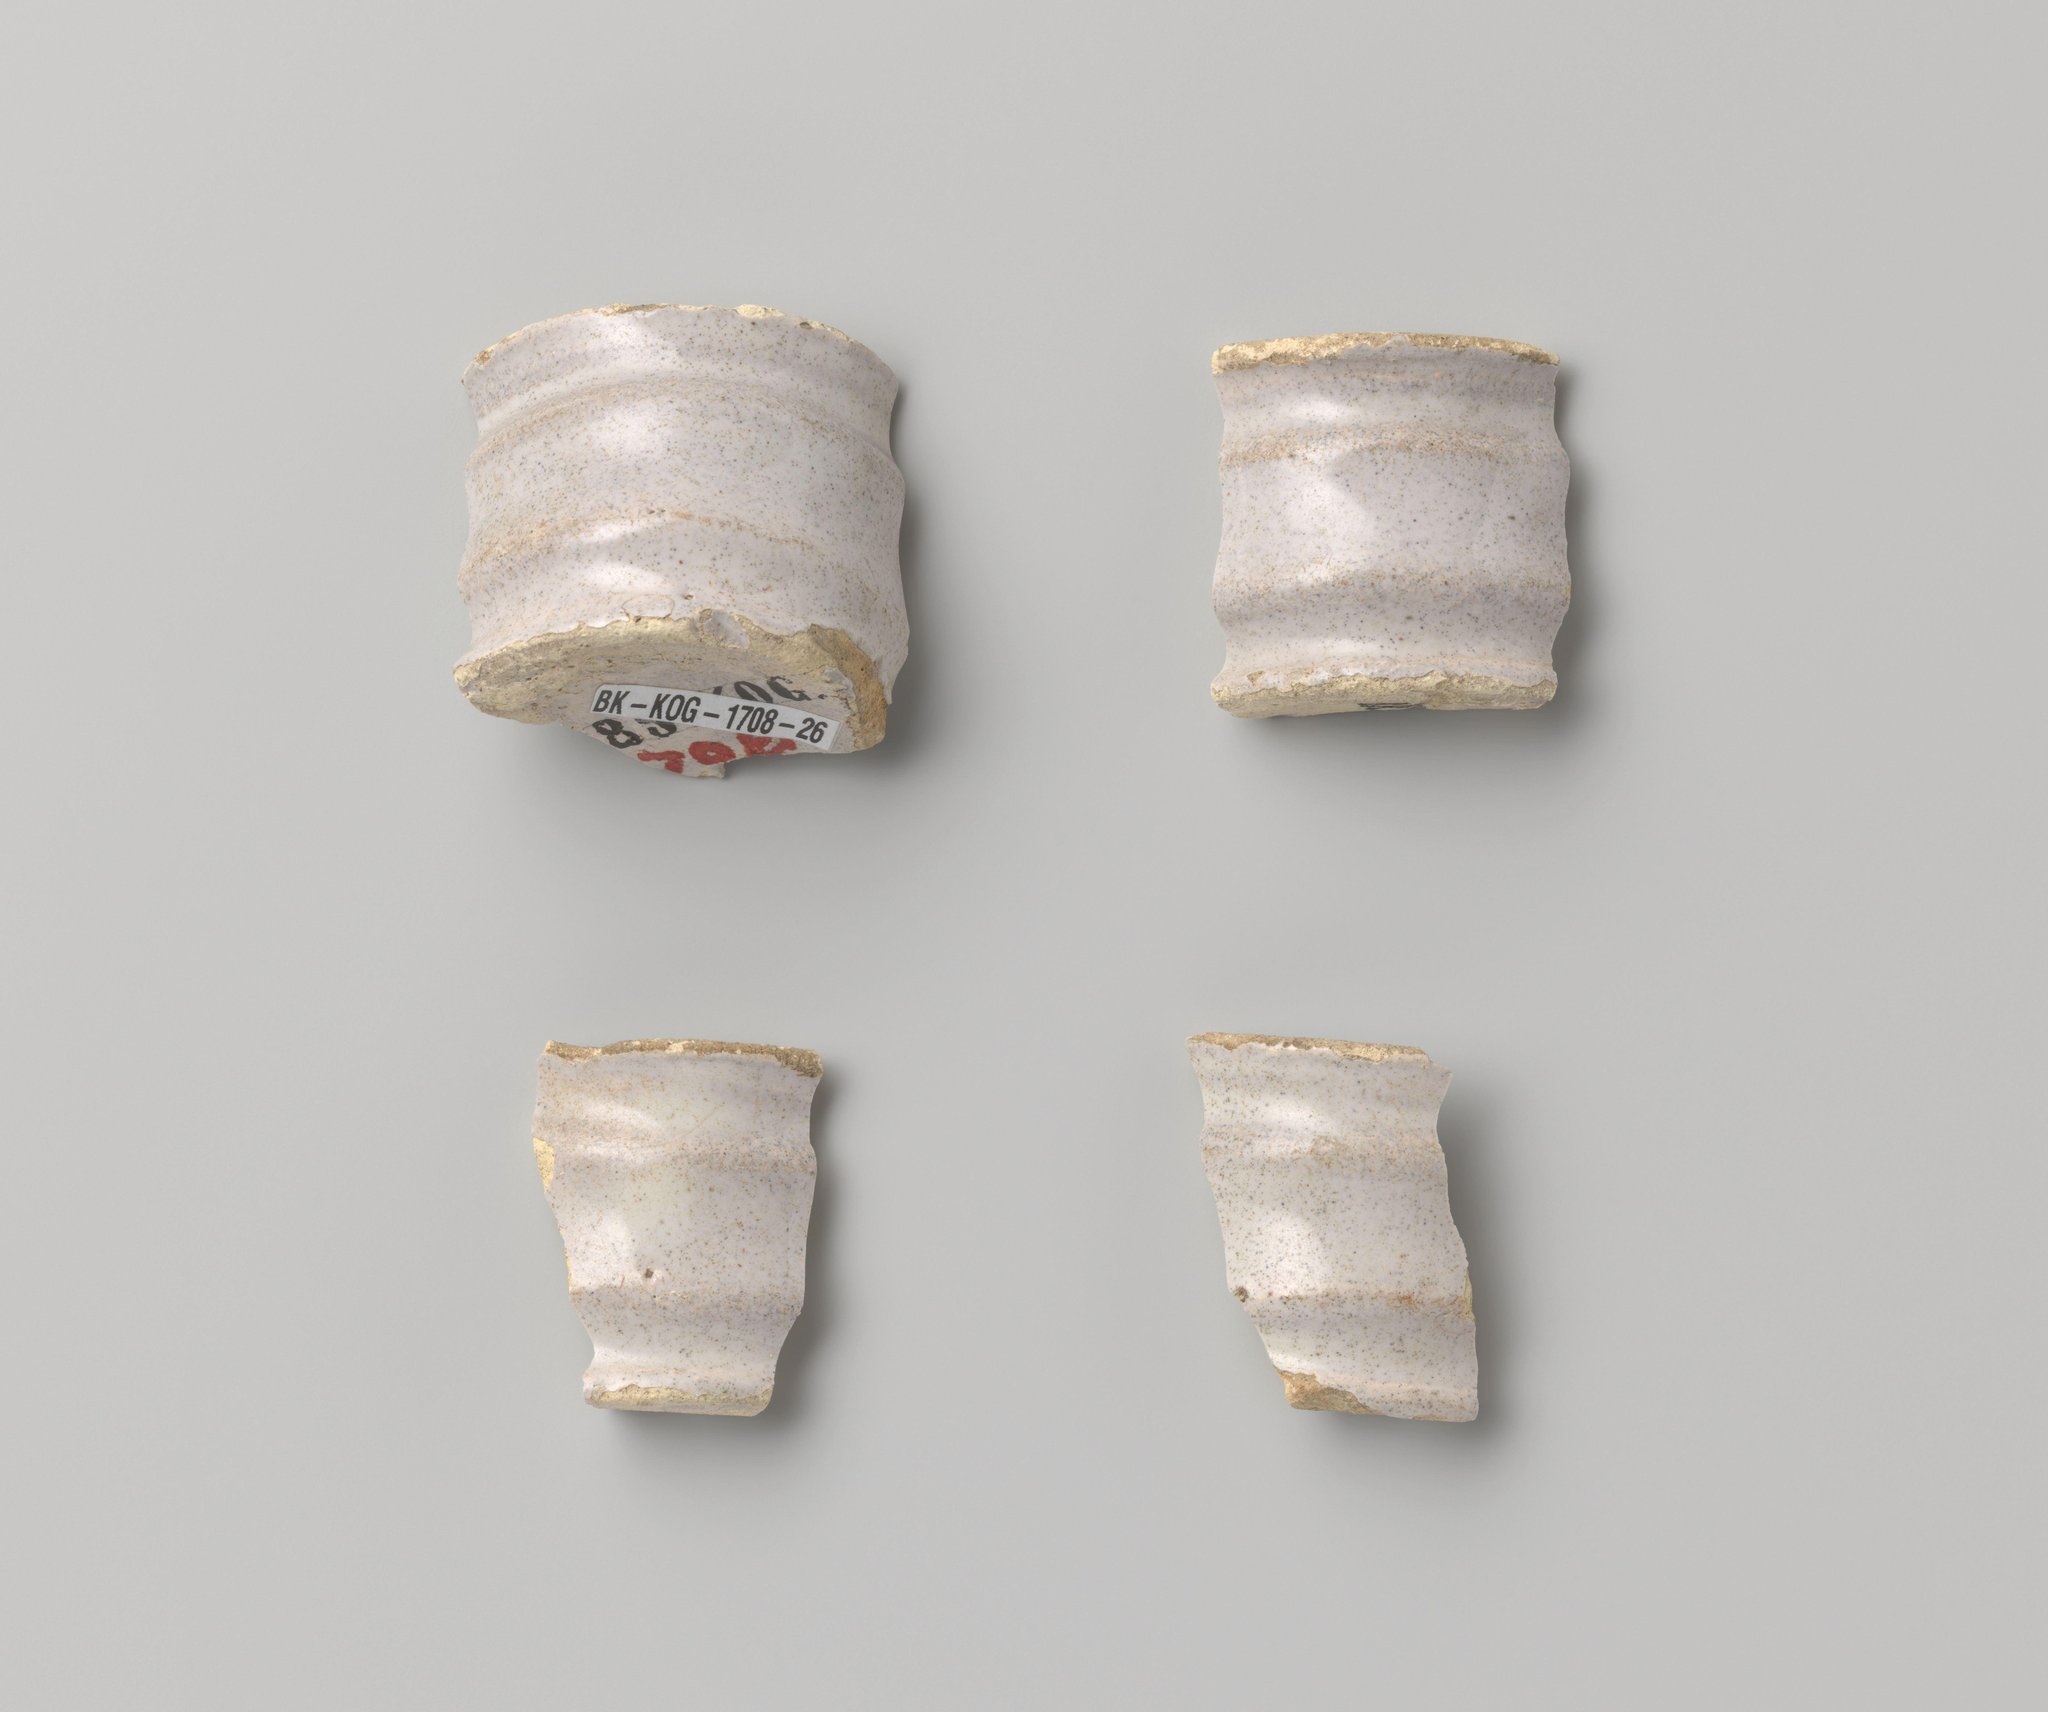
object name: ointment vessel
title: Witte zalfpot van aardewerk, van binnen en buiten voorzien van kleurloos loodglazuur, incompleet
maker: Anonymous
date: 1500-1799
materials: earthenware, glaze